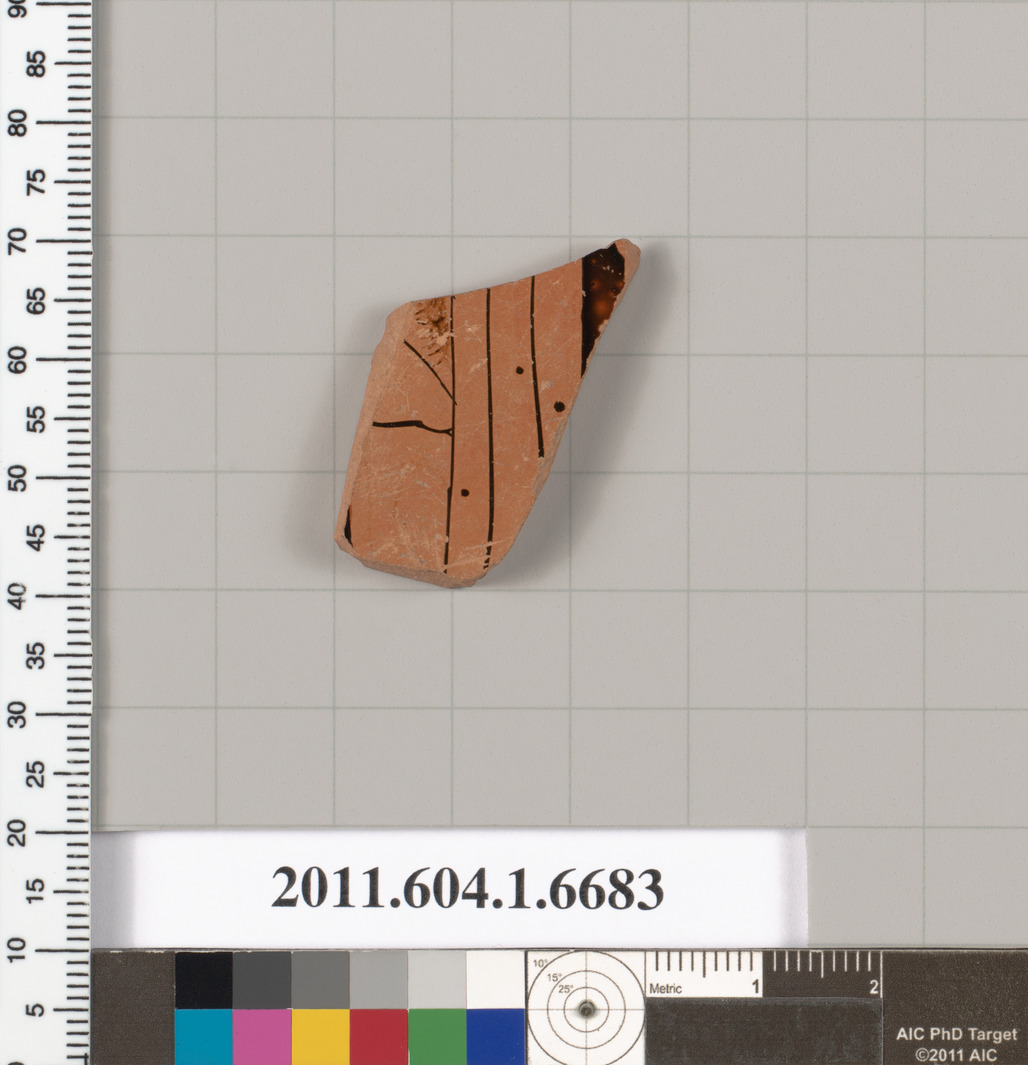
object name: kylix fragment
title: Terracotta fragment of a kylix (drinking cup)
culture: greek, attic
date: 490-470 BCE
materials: terracotta